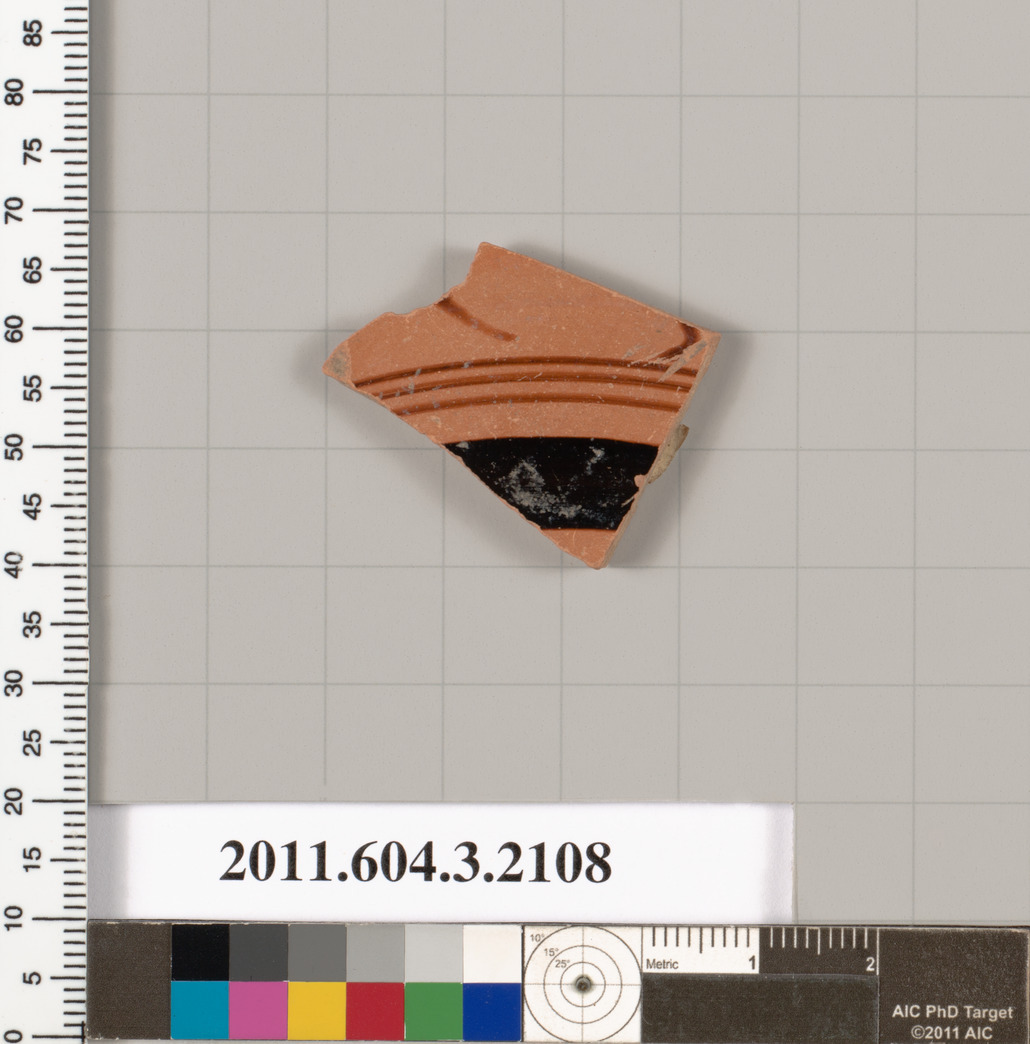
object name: kylix fragment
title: Terracotta fragment of a kylix (drinking cup)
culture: greek, attic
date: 534-501 BCE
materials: terracotta